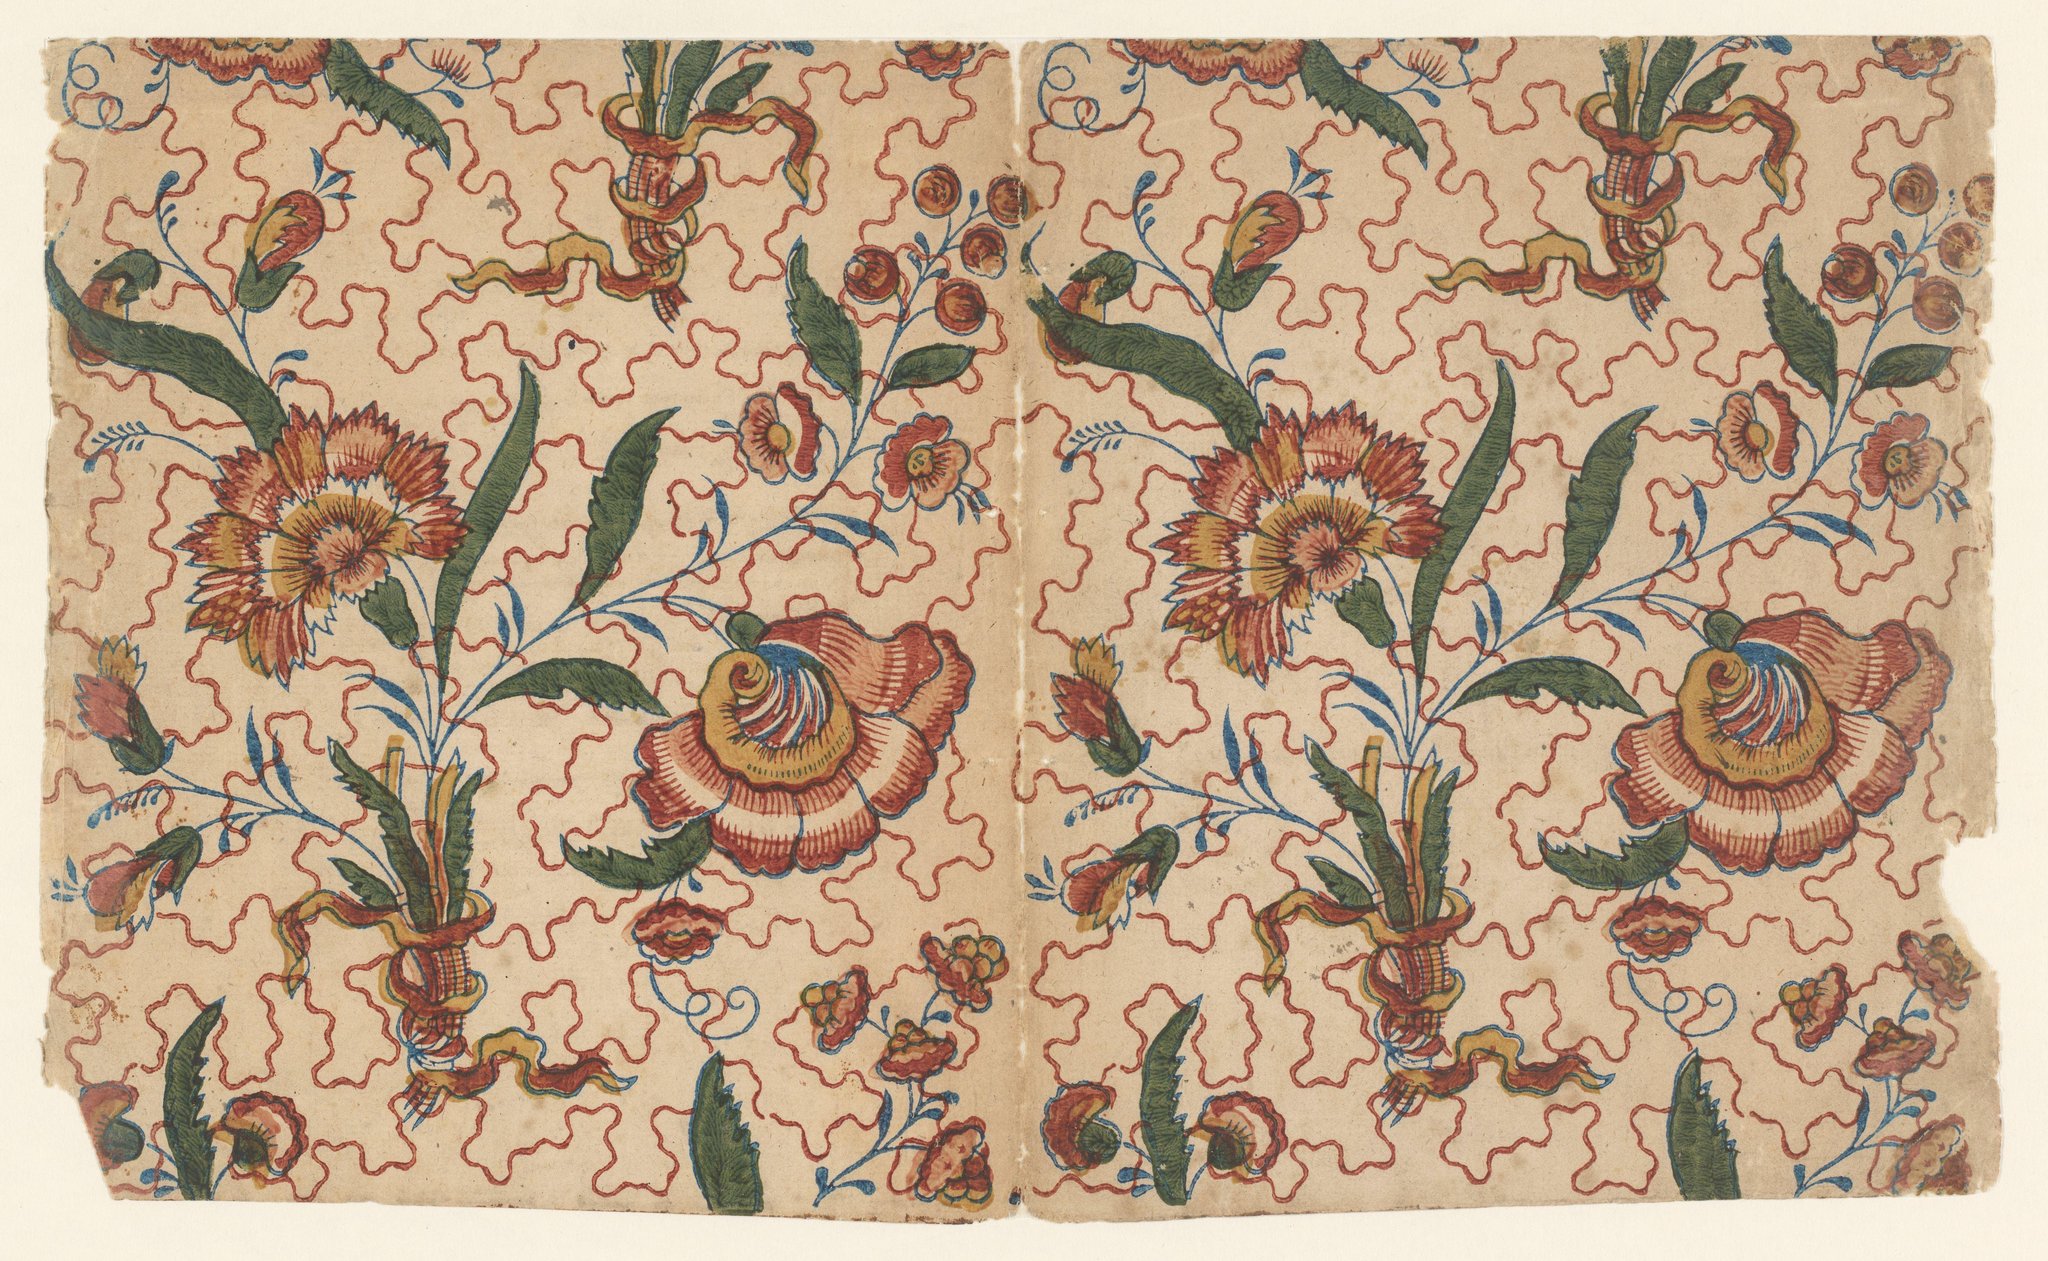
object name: wrapper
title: Twee bladen met bloemboeketten tussen kronkellijnen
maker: Anonymous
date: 1700-1850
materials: paper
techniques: printing block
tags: ornament derived from plant forms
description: Twee bladen met bloemboeketten tussen kronkellijnen. Twee losse helften van een omslag, opgezet op één blad.